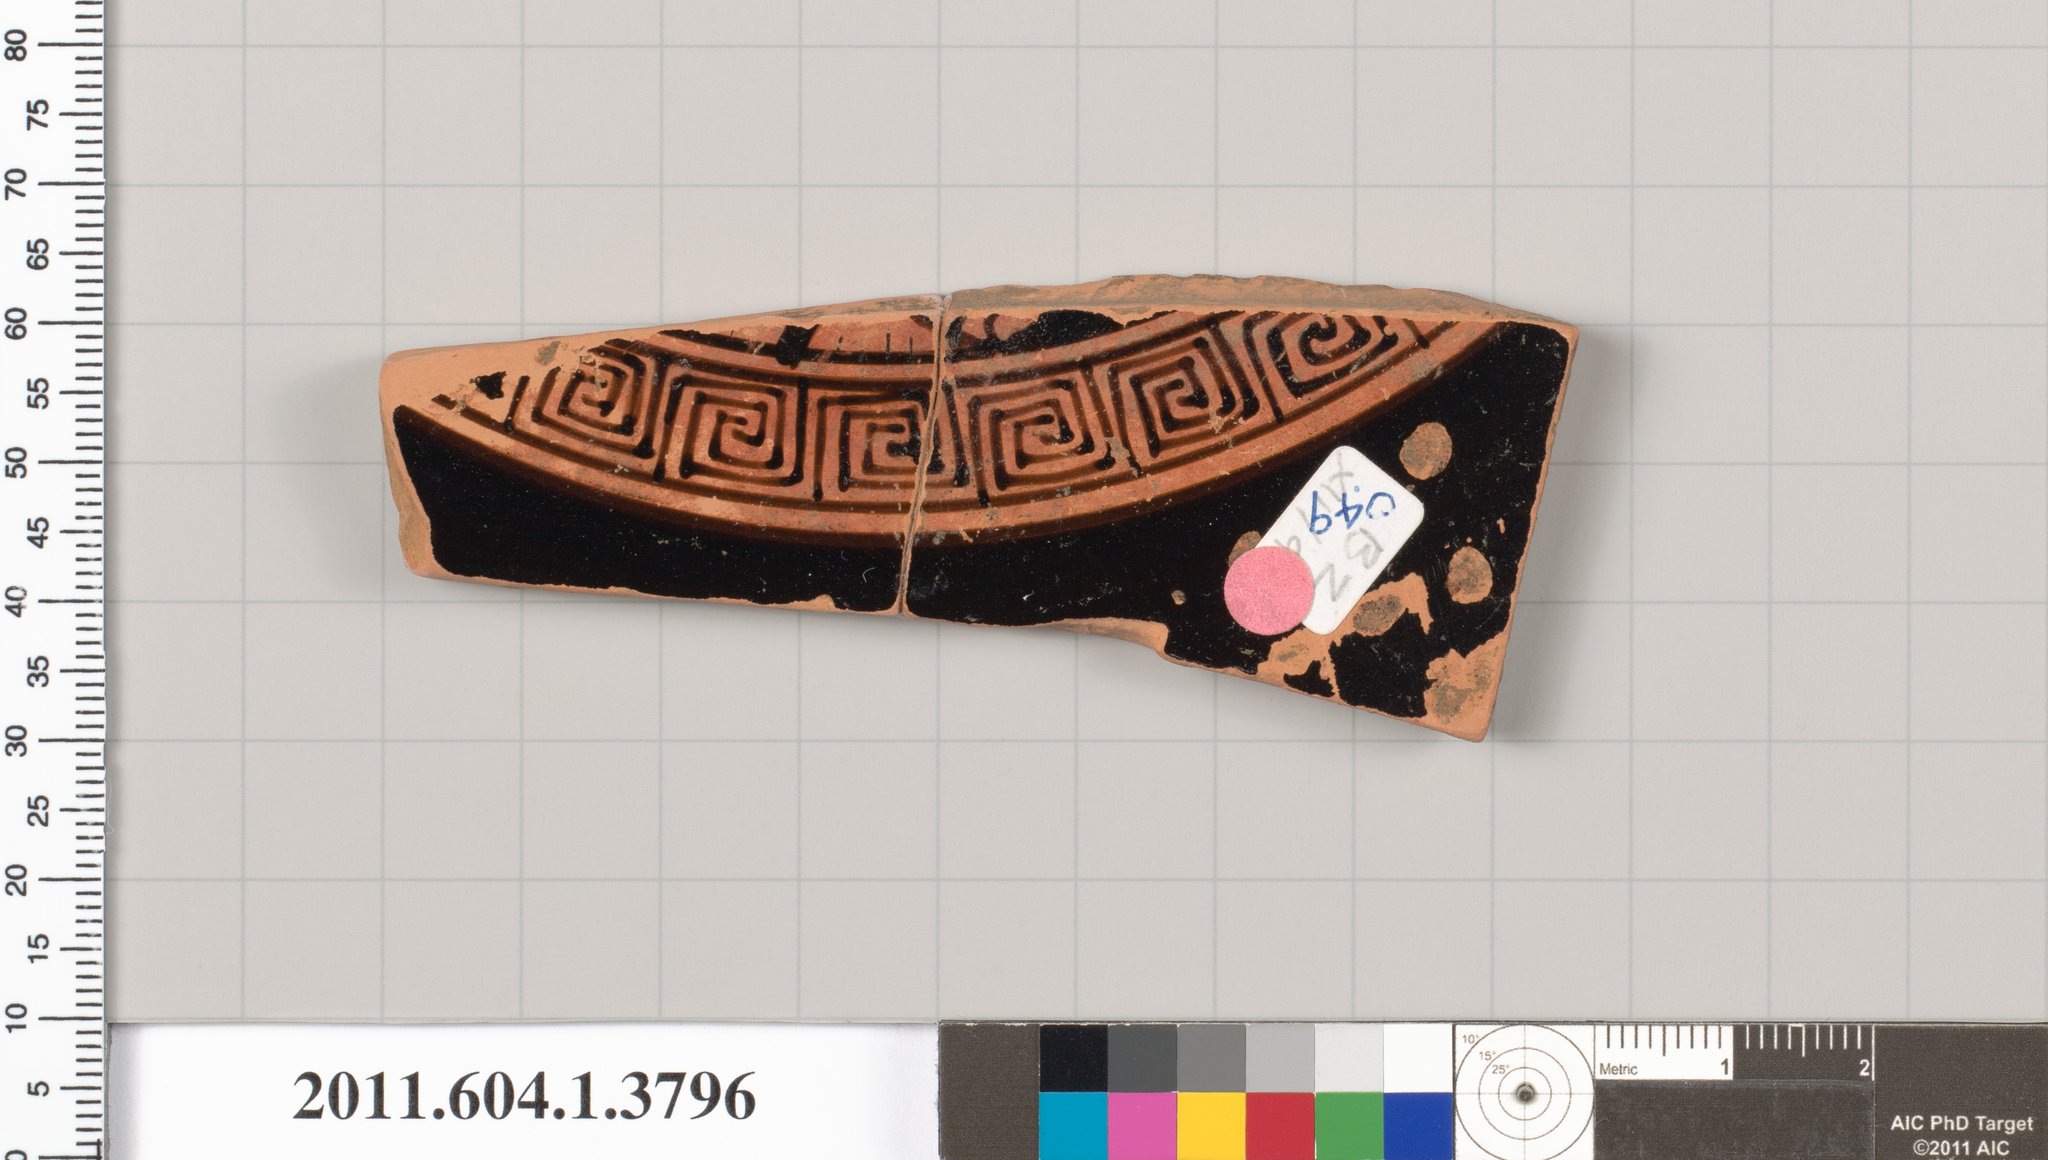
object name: kylix fragment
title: Terracotta fragment of a kylix (drinking cup)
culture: greek, attic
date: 475-451 BCE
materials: terracotta